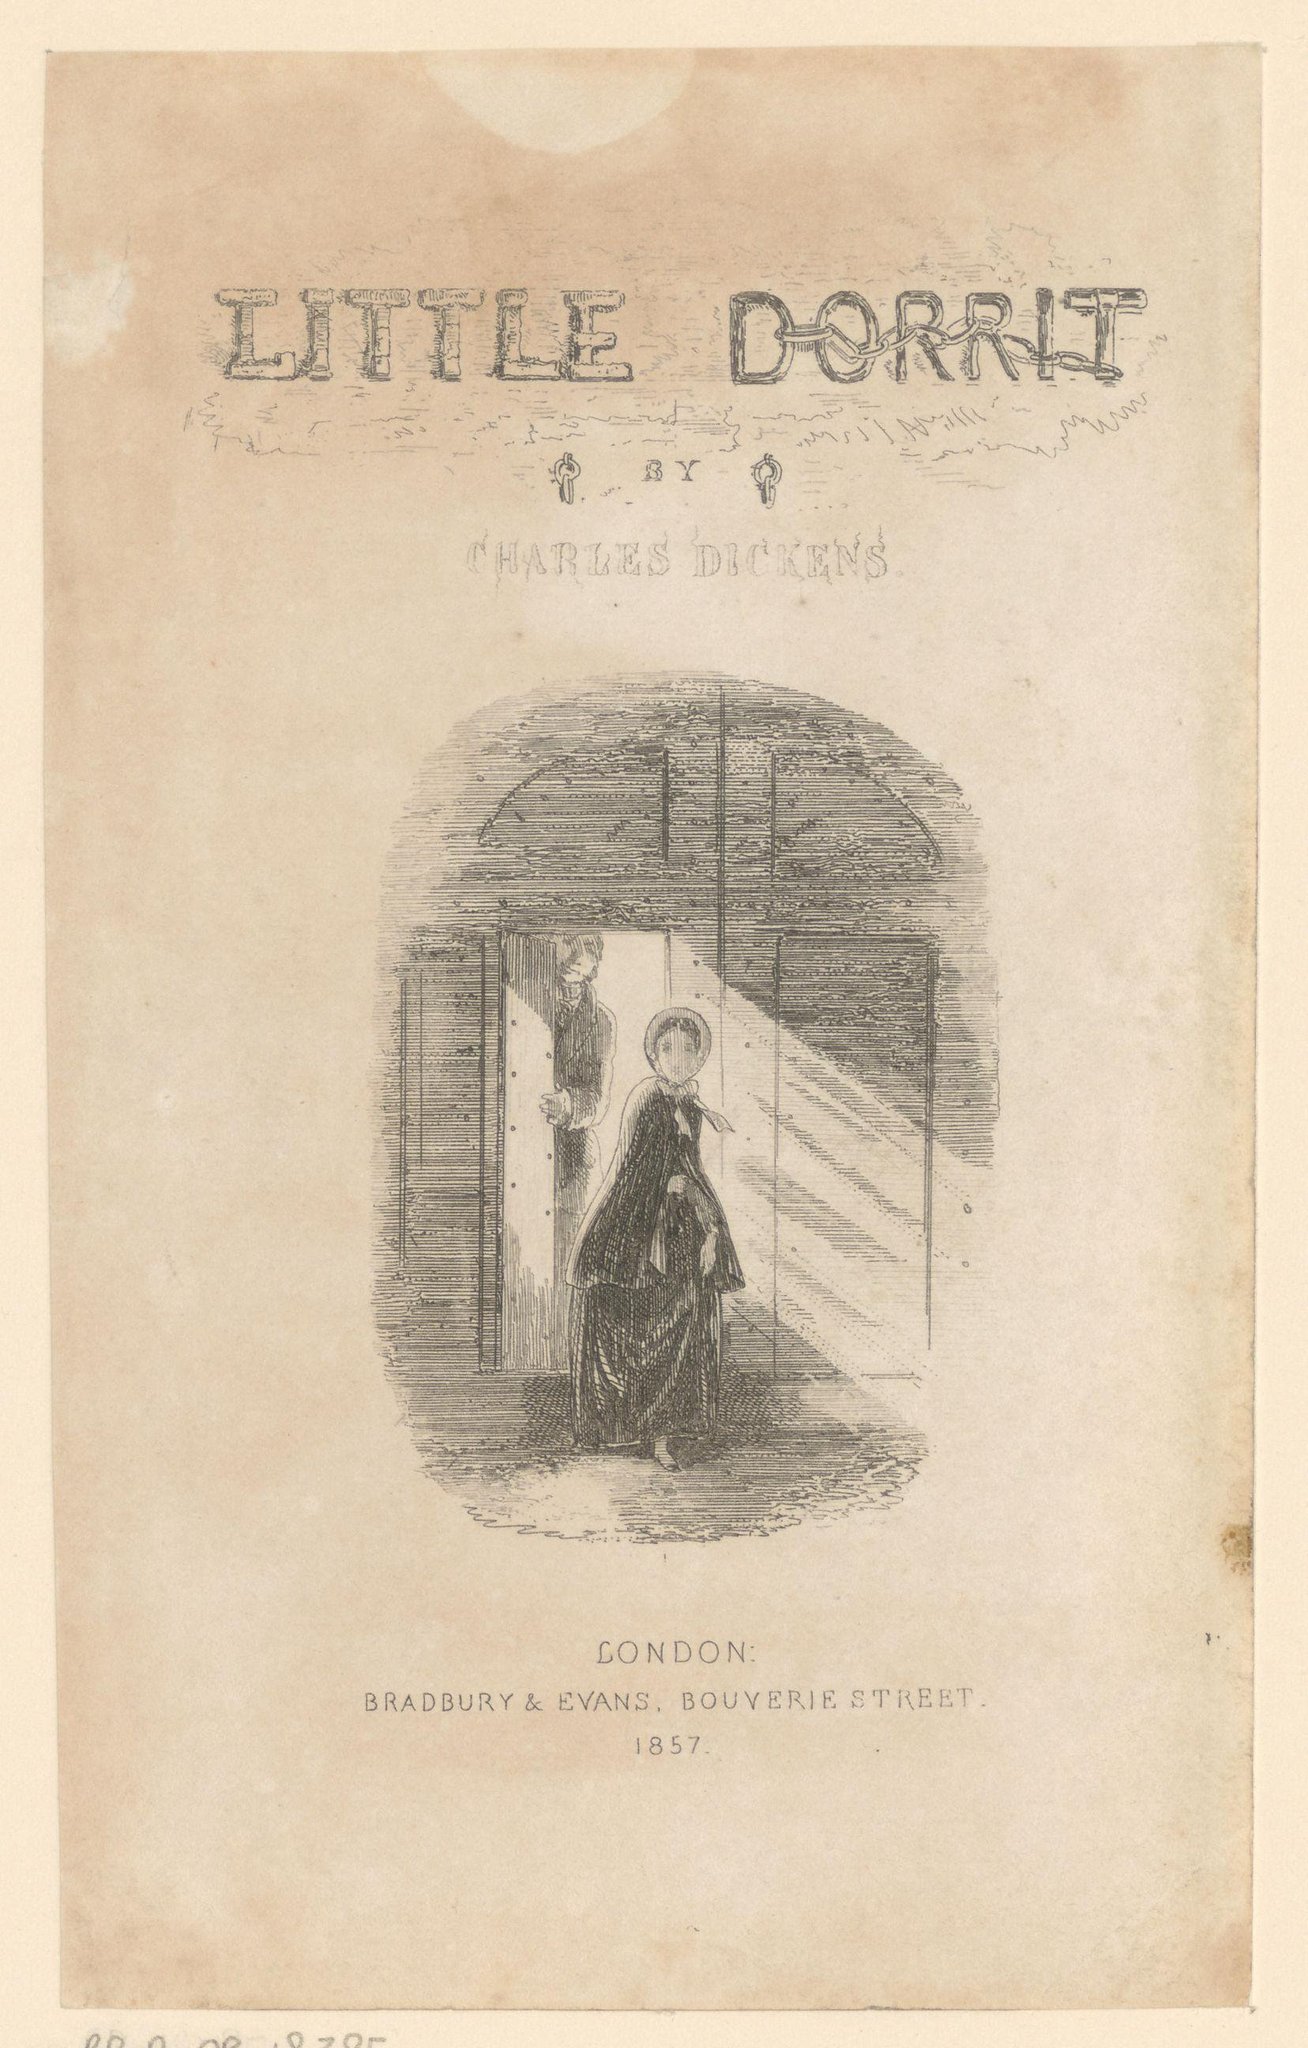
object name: titelblad, titelpagina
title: Vrouw stapt uit een deuropening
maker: hablot knight browne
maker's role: print maker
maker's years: 1815-1882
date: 1857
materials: paper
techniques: etching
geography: london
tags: open door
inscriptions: collector's mark: Lugt 2228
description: Titelpagina voor: Dickens, Charles. Little Dorrit. Londen: Bradbury & Evans, 1857.